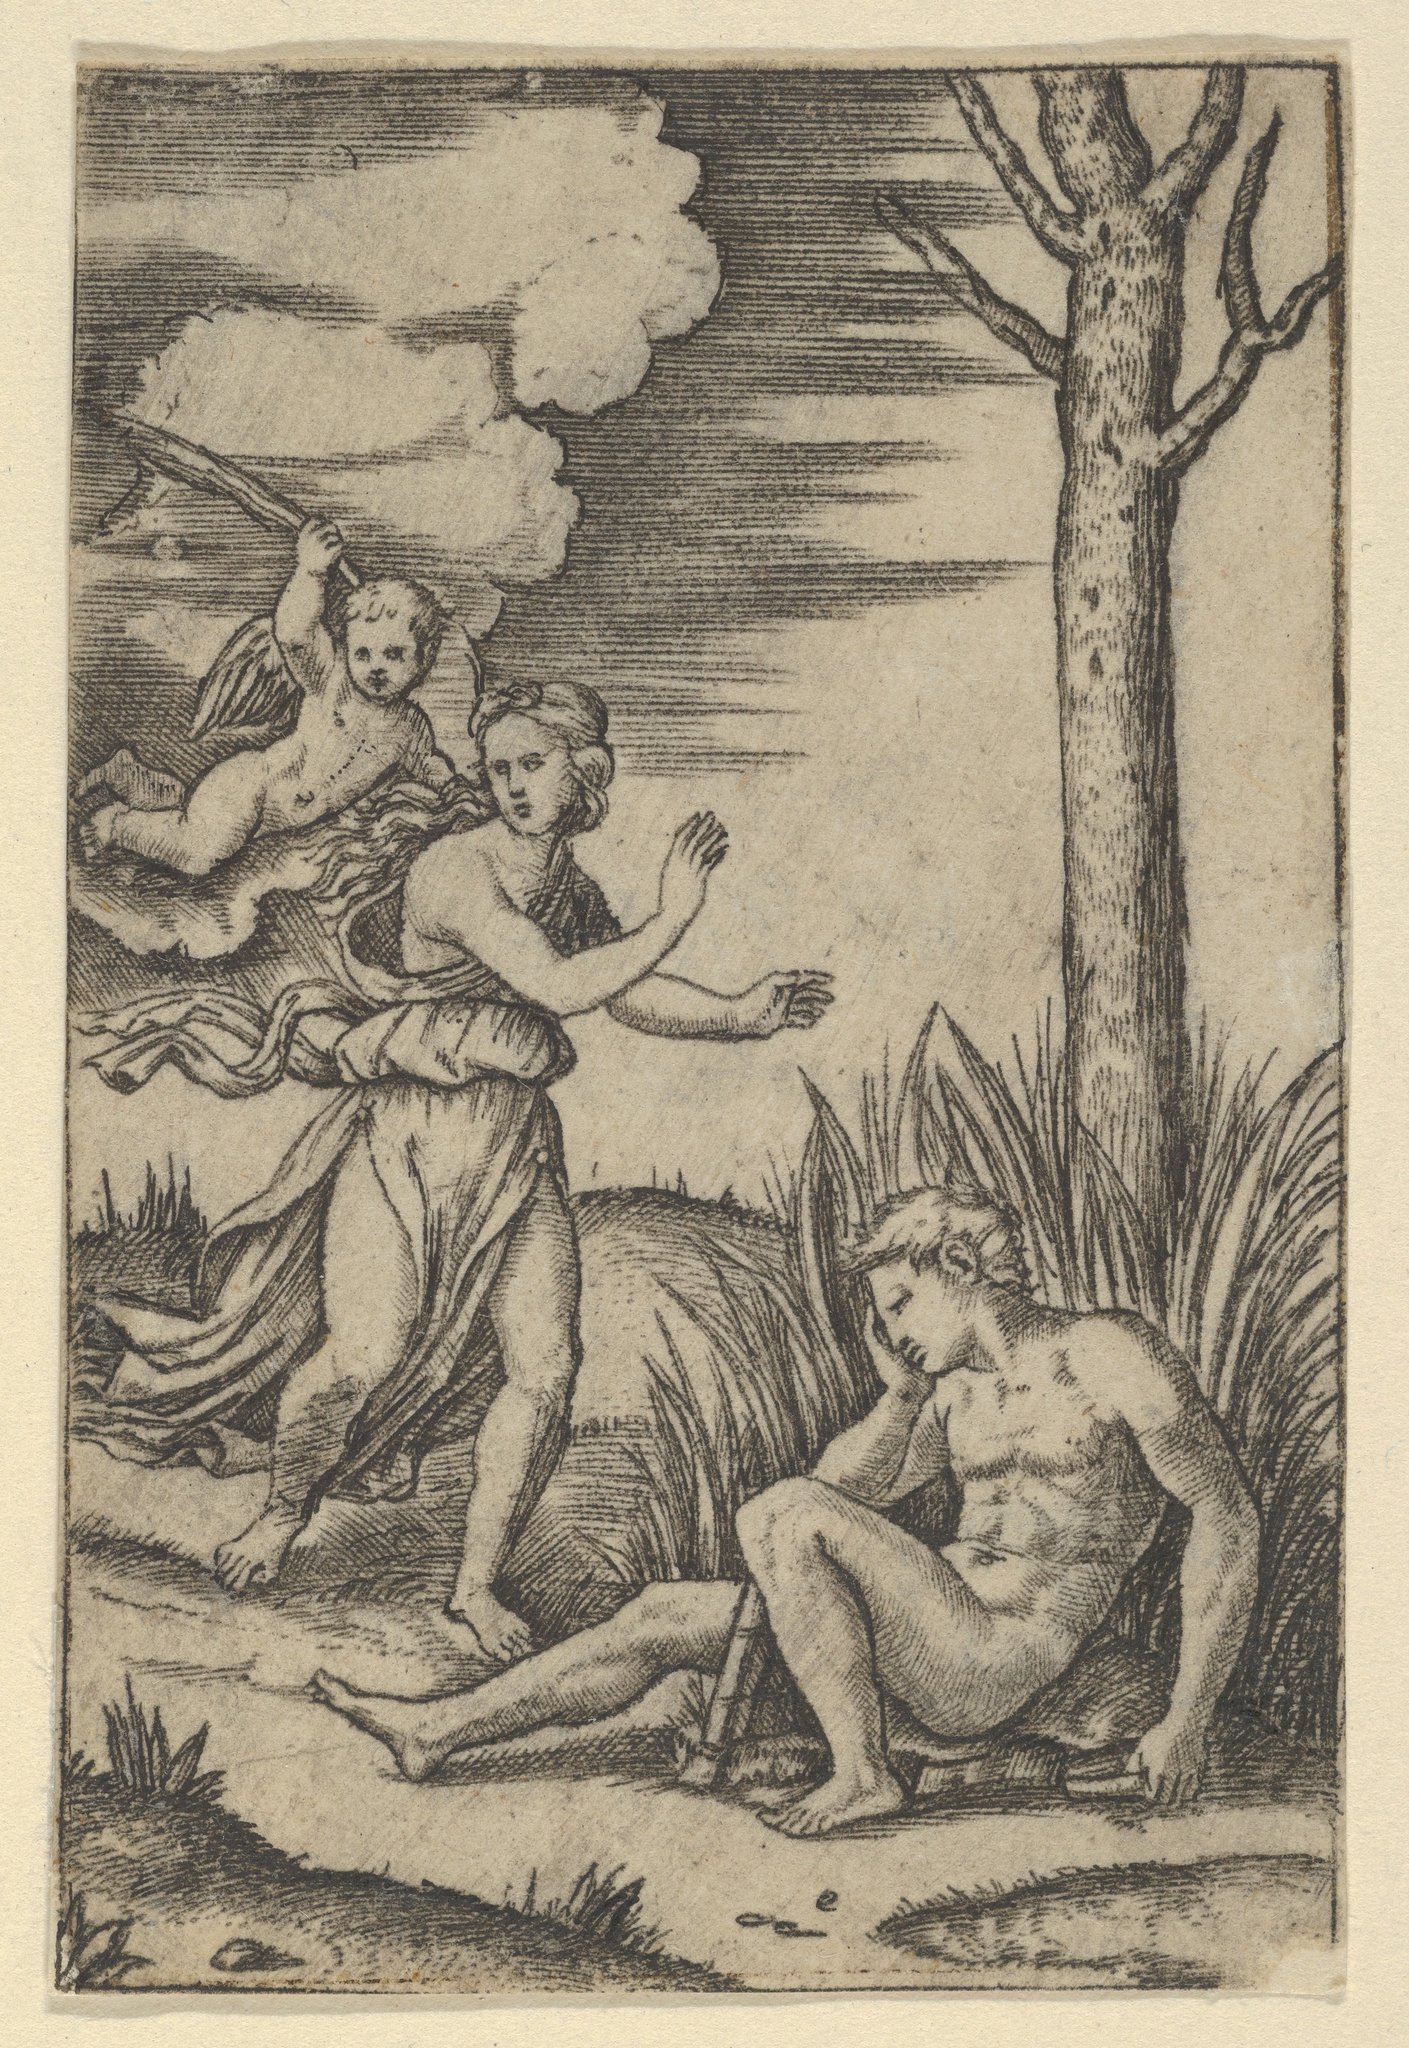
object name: print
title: Diana followed by cupid at left, Endymion at right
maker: marcantonio raimondi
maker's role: artist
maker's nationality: italian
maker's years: 1475-1534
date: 1500-1534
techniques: engraving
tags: men,cupid,diana